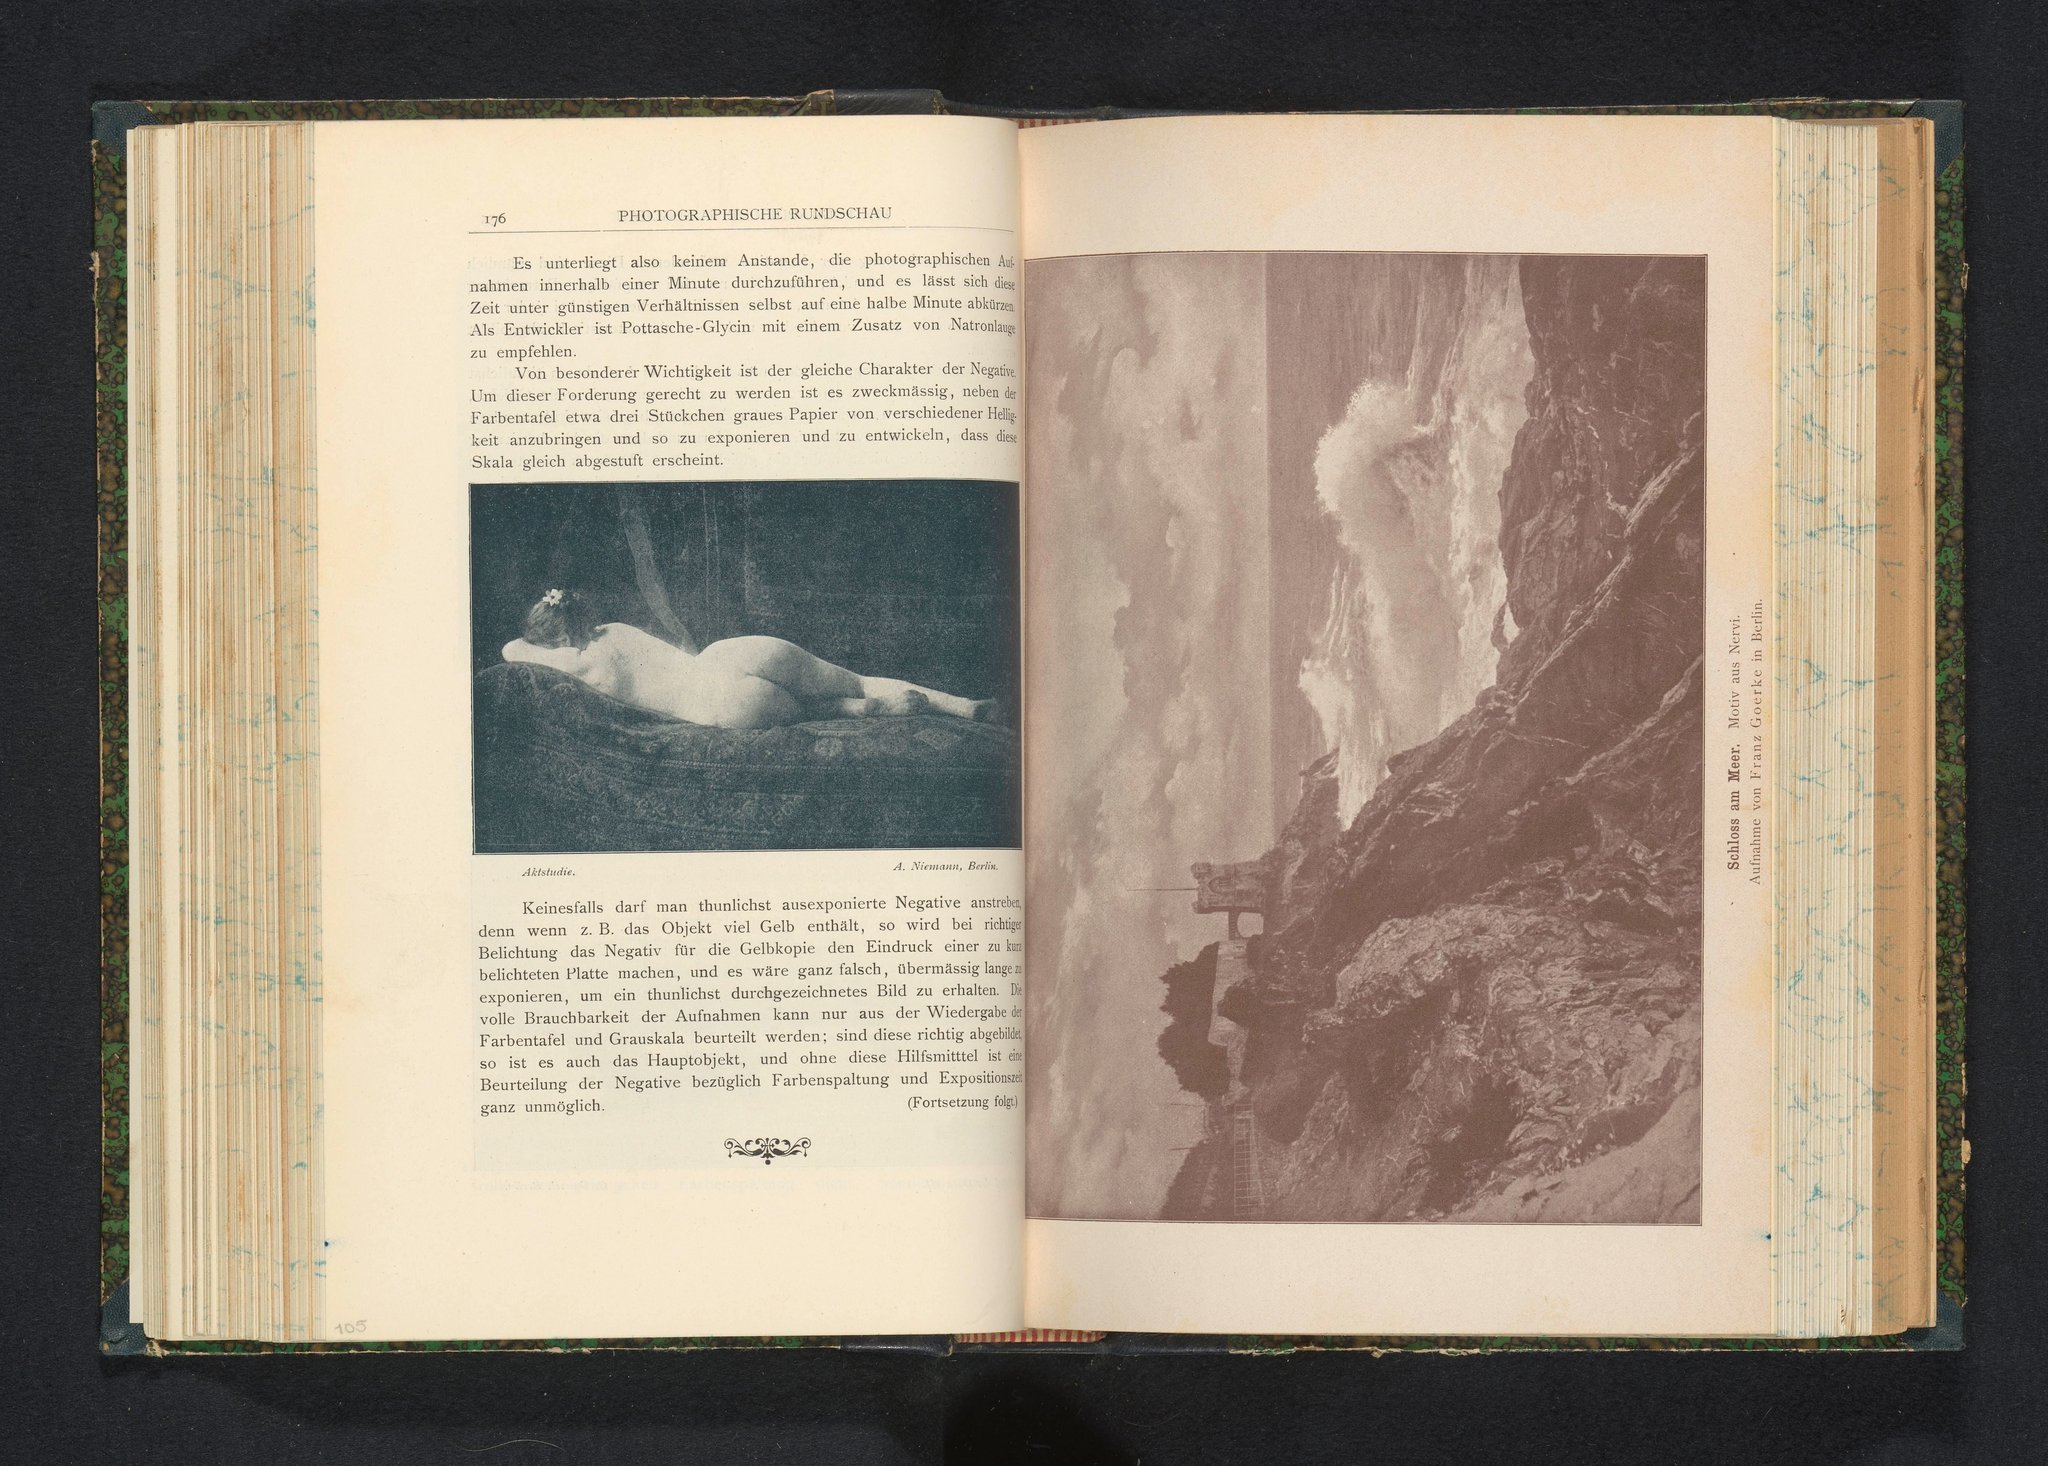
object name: page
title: Aktstudie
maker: a. niemann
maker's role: fotograaf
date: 1894-1899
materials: paper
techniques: autotype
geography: berlin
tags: historical persons not known by name - bb - woman